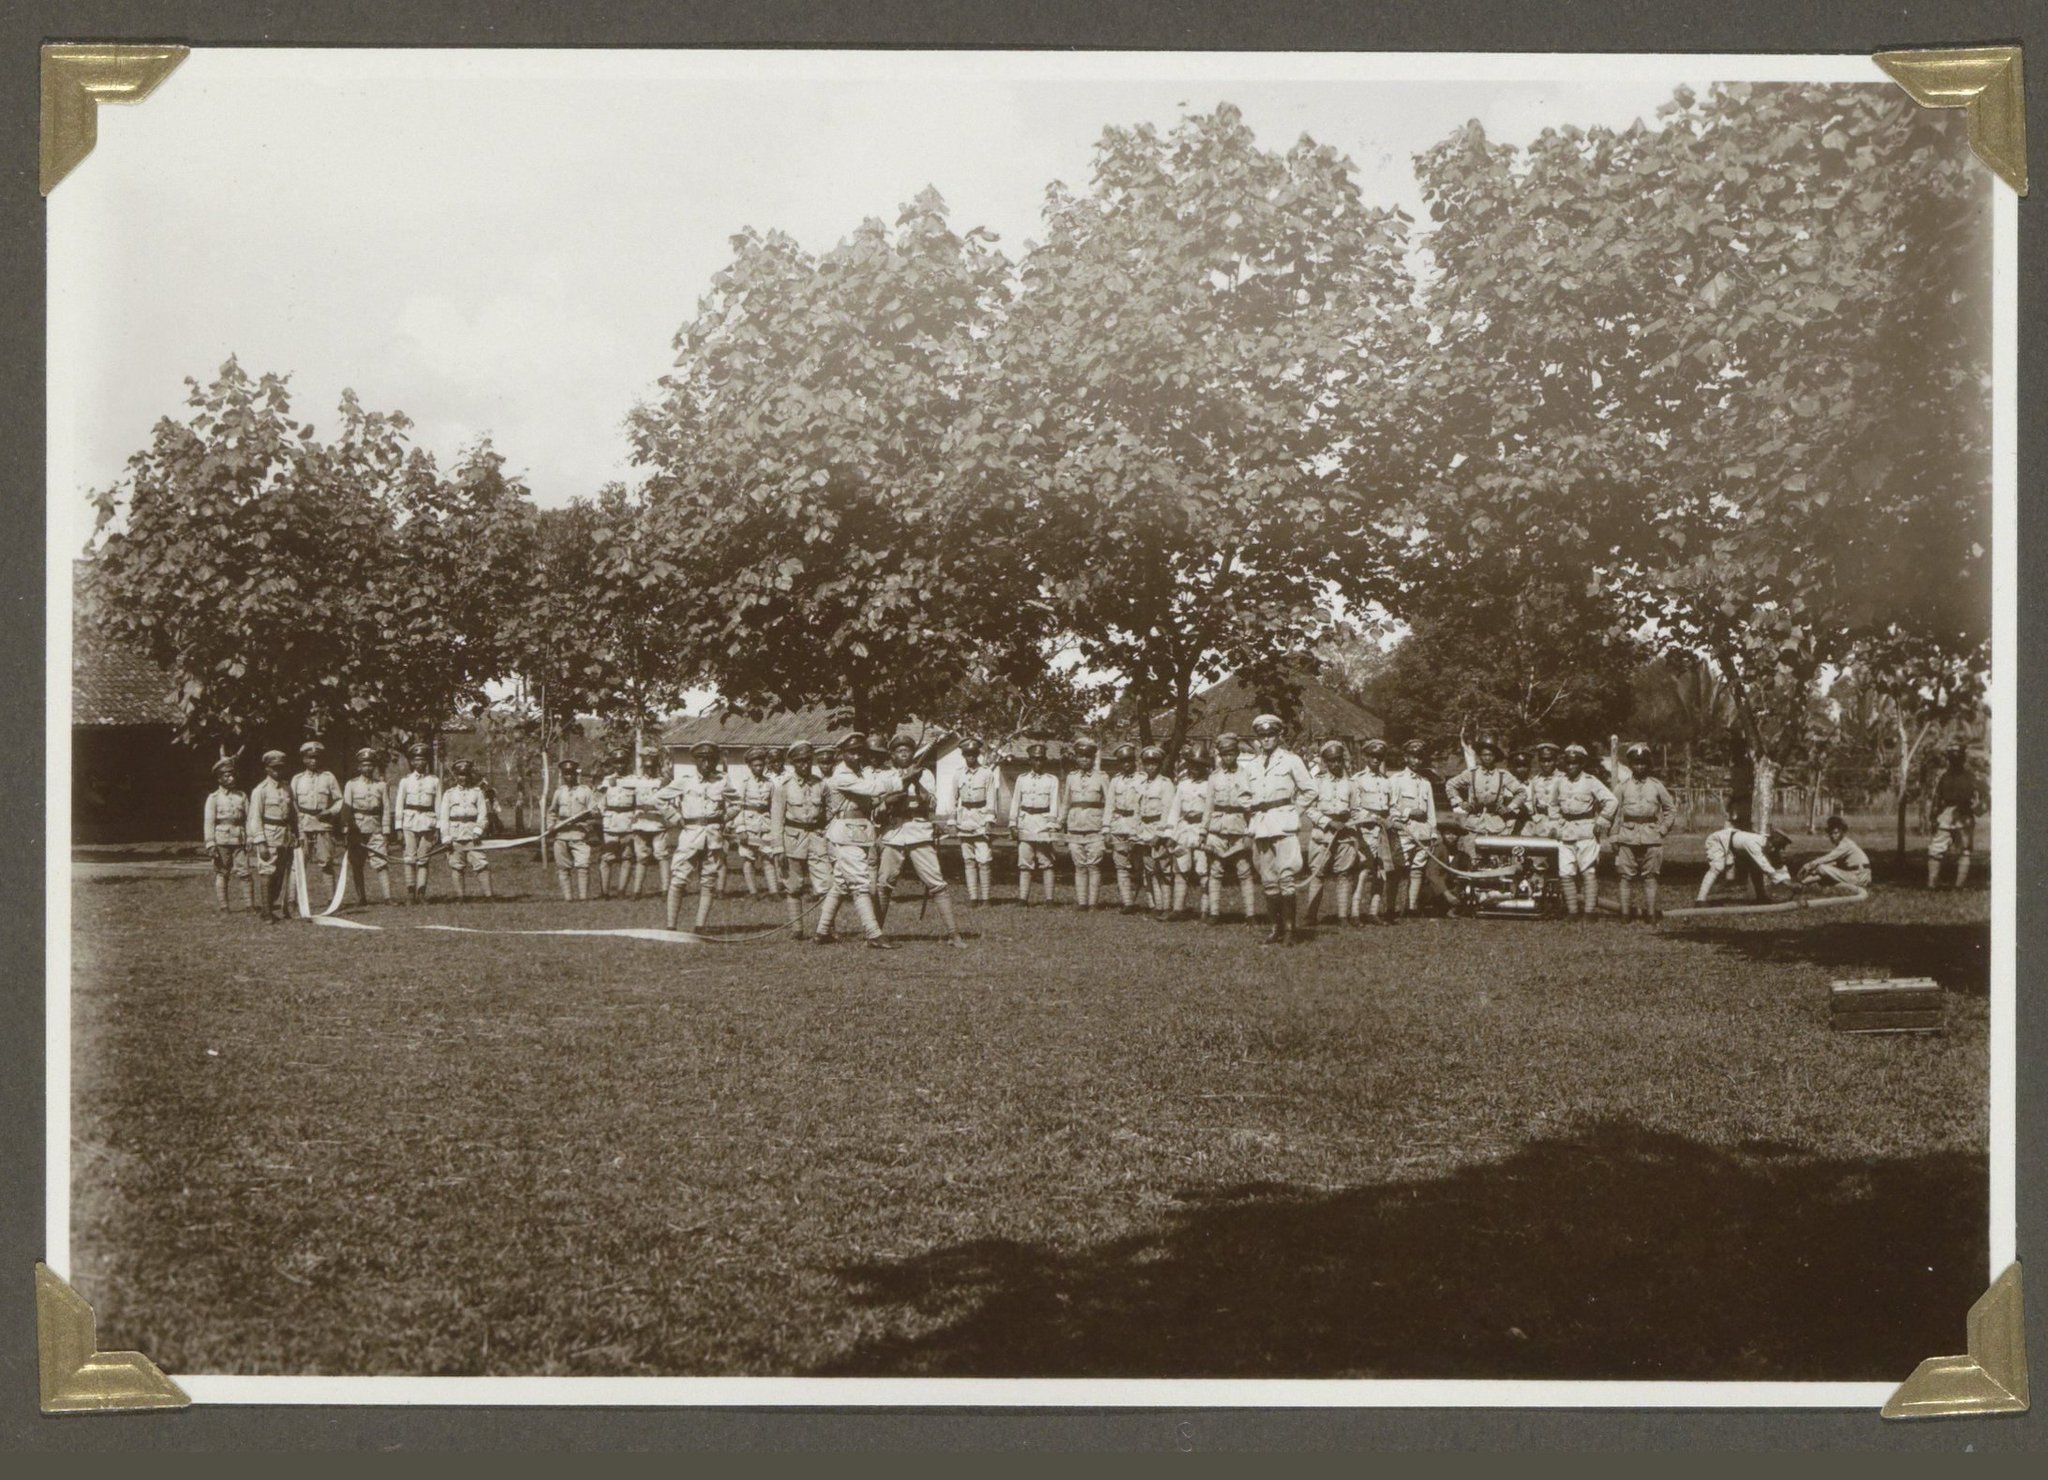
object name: photograph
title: Groepsportret van de politiebrandweer en de veldpolitie in Lampong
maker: Anonymous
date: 1932-1933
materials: photographic support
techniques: gelatin silver print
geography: lampung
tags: firemen, police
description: Onderdeel van Herinneringsalbum voor F.J. Junius, vertrekkend resident van Lampong (Zuid-Sumatra).